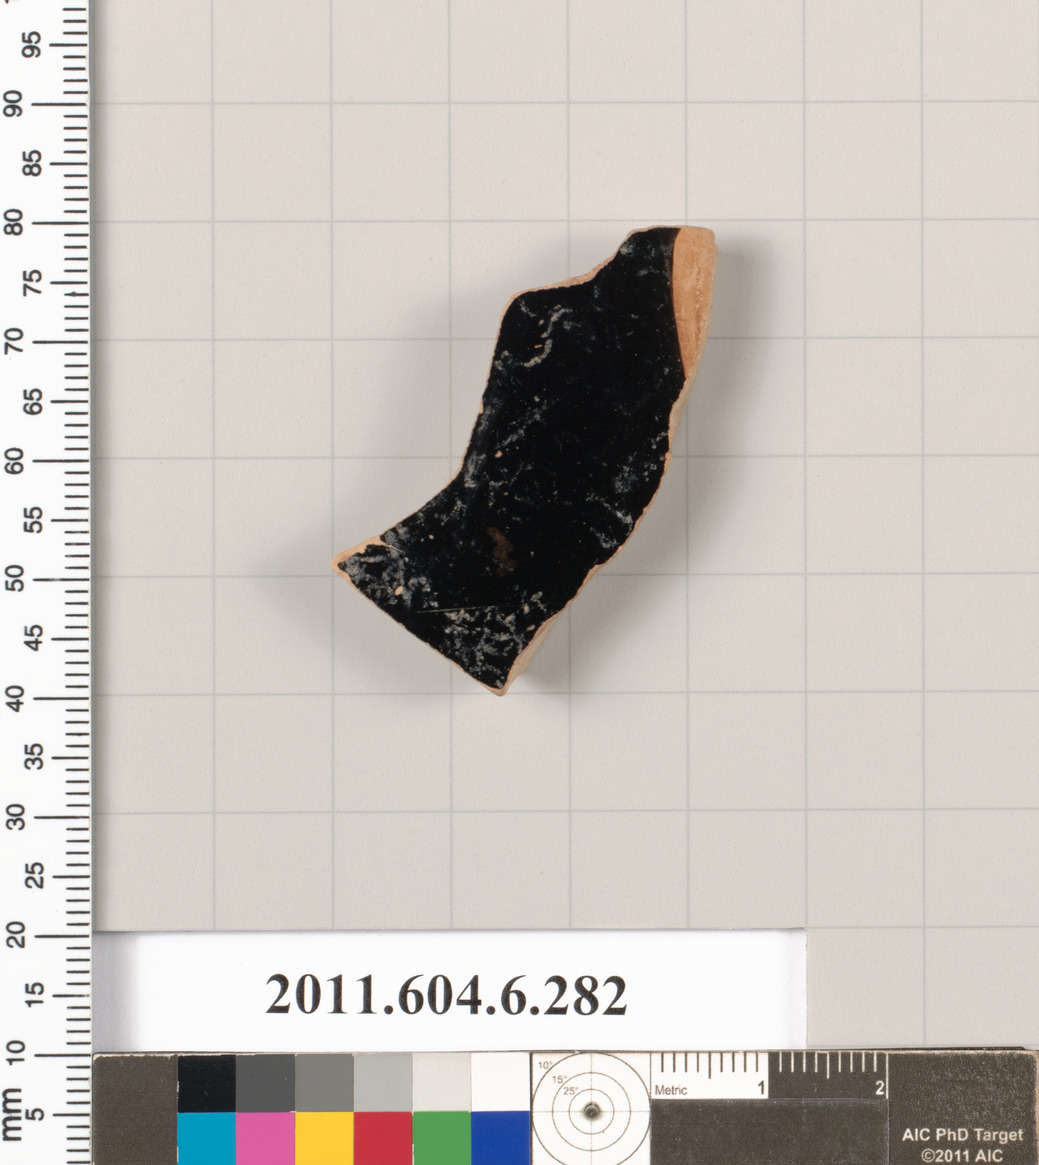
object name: undetermined open shape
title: Terracotta fragment of an open shape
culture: greek, attic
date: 600-301 BCE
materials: terracotta